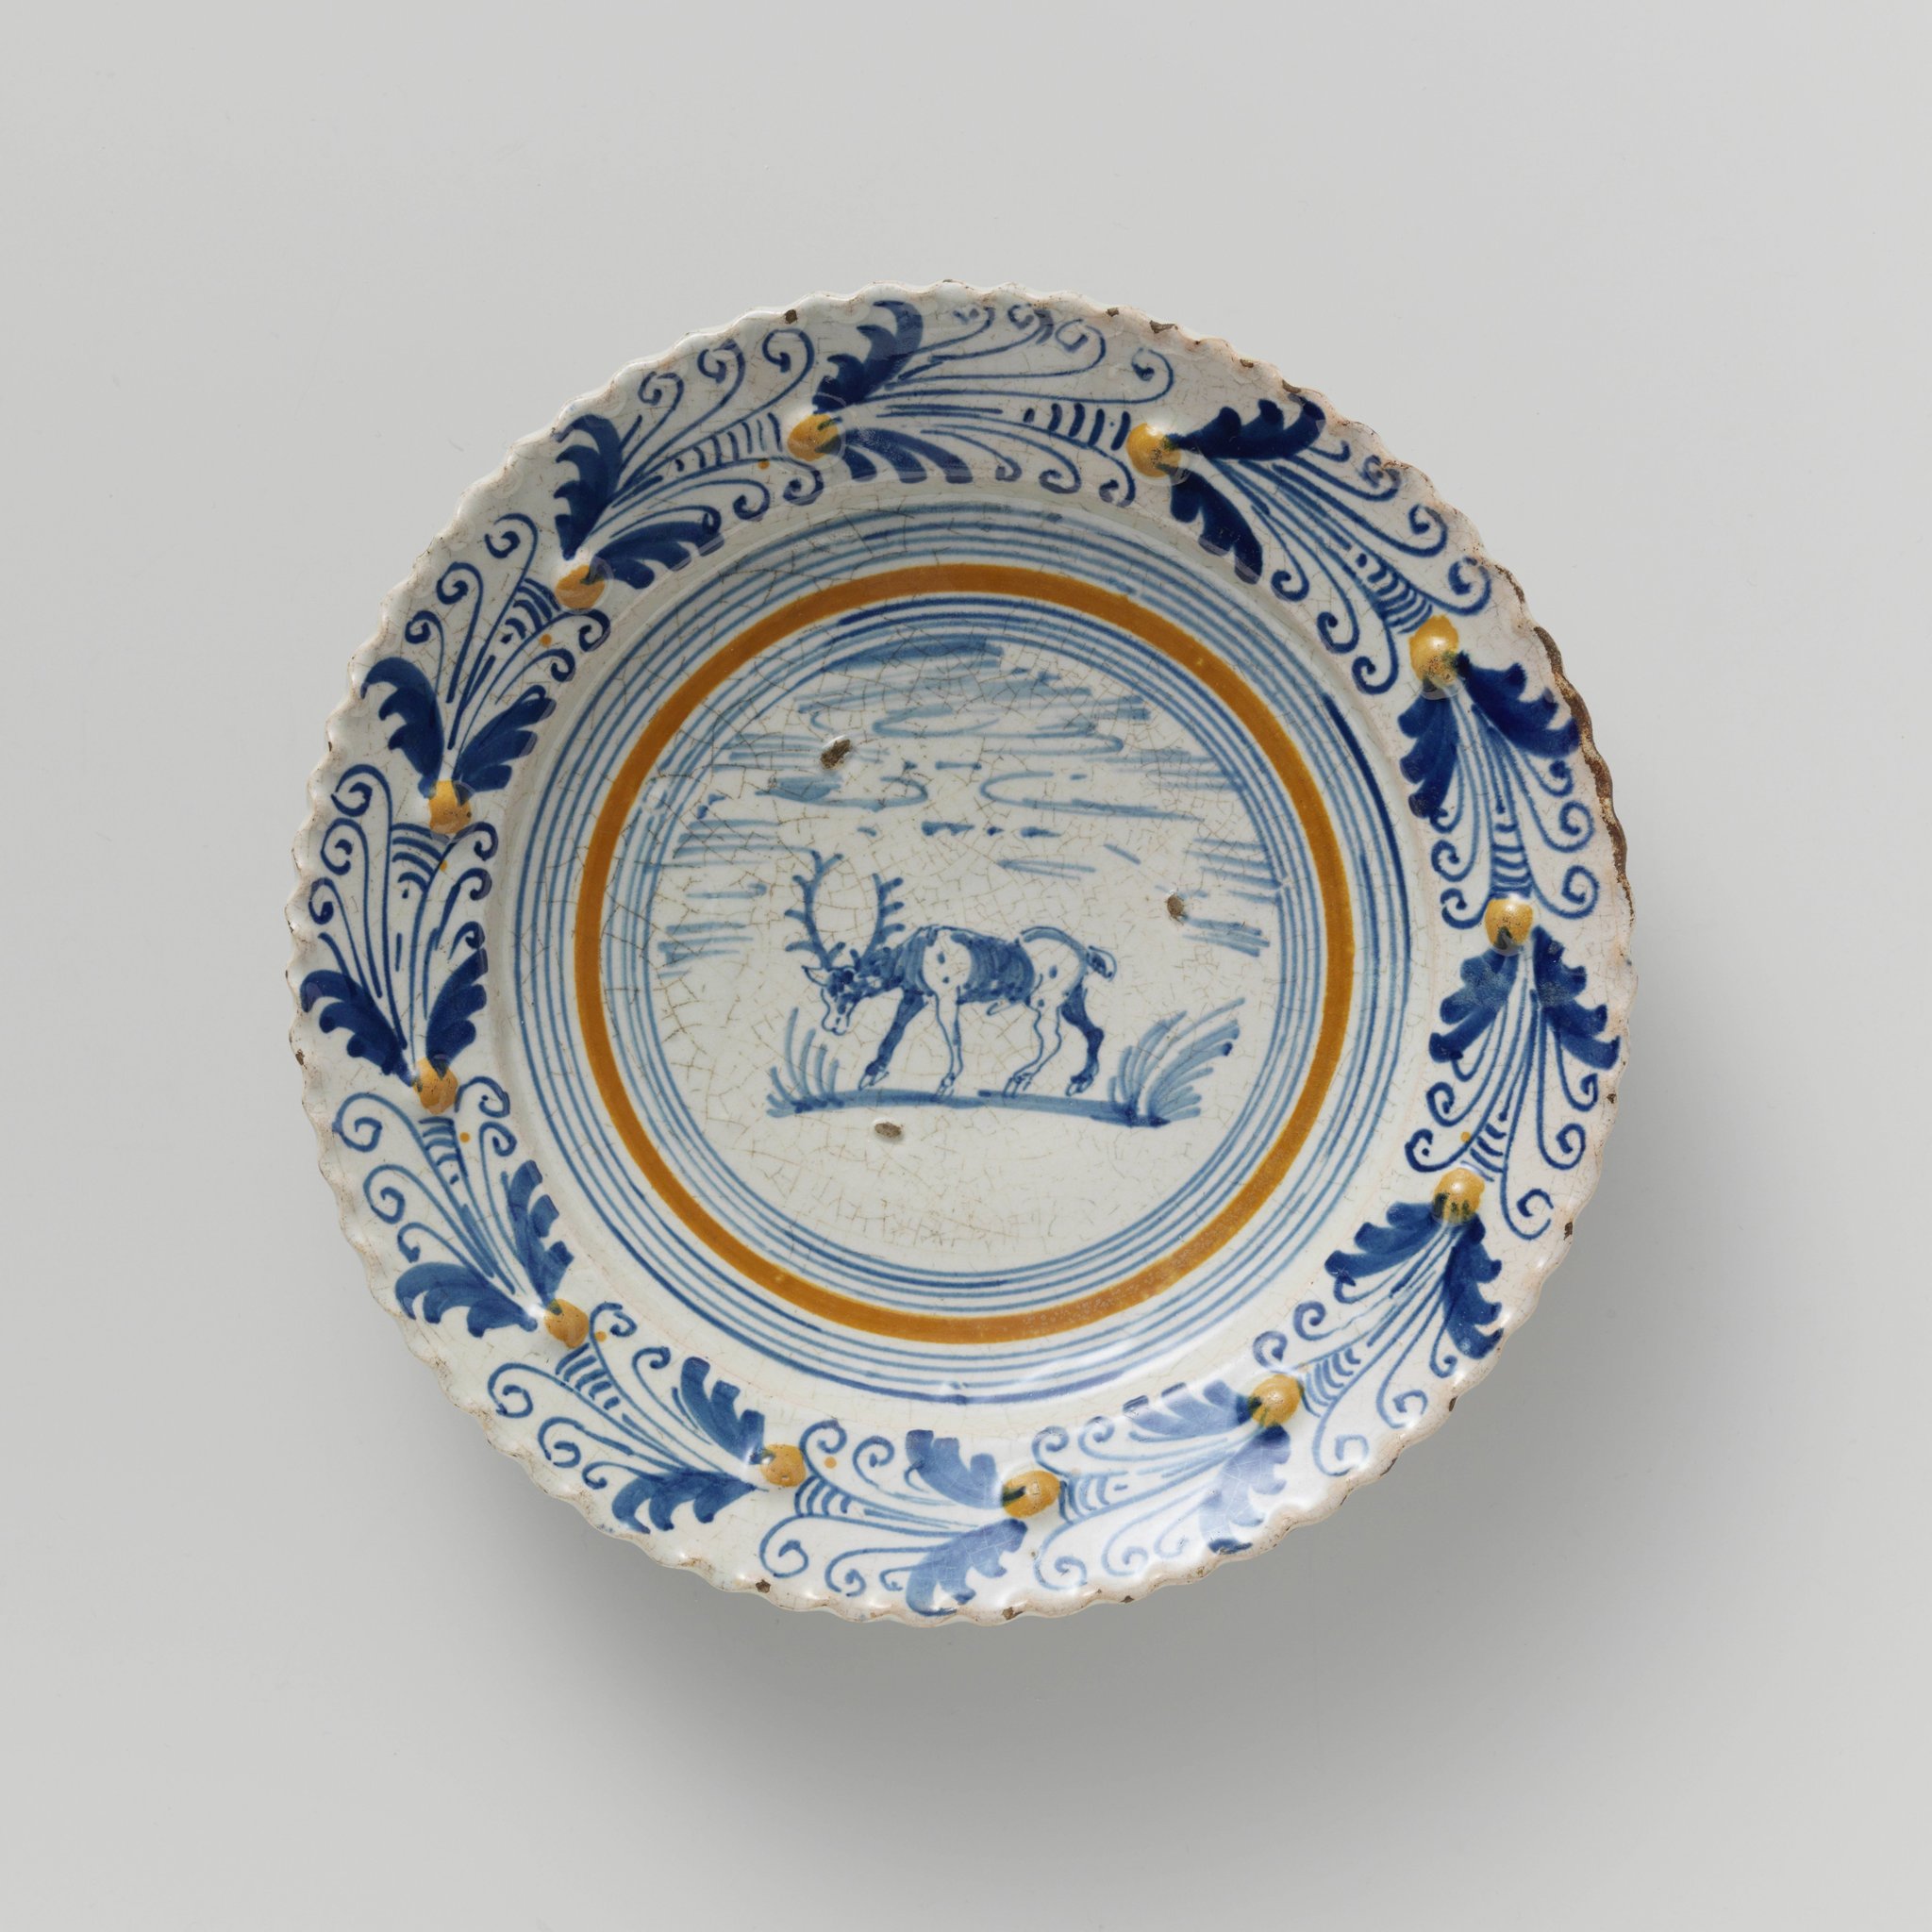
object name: plate dish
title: Bord, veelkleurig beschilderd met op het plat binnen concentrische cirkels een hert. Geschulpte rand met noppen.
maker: Anonymous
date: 1620-1635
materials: earthenware, glaze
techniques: maiolica, painted, polychromy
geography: netherlands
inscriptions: : ‘BK 23’, : ‘verzameling F. Bodenheim Amsterdam/ nr. 253’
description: Dish, c. 1610 - 1640.